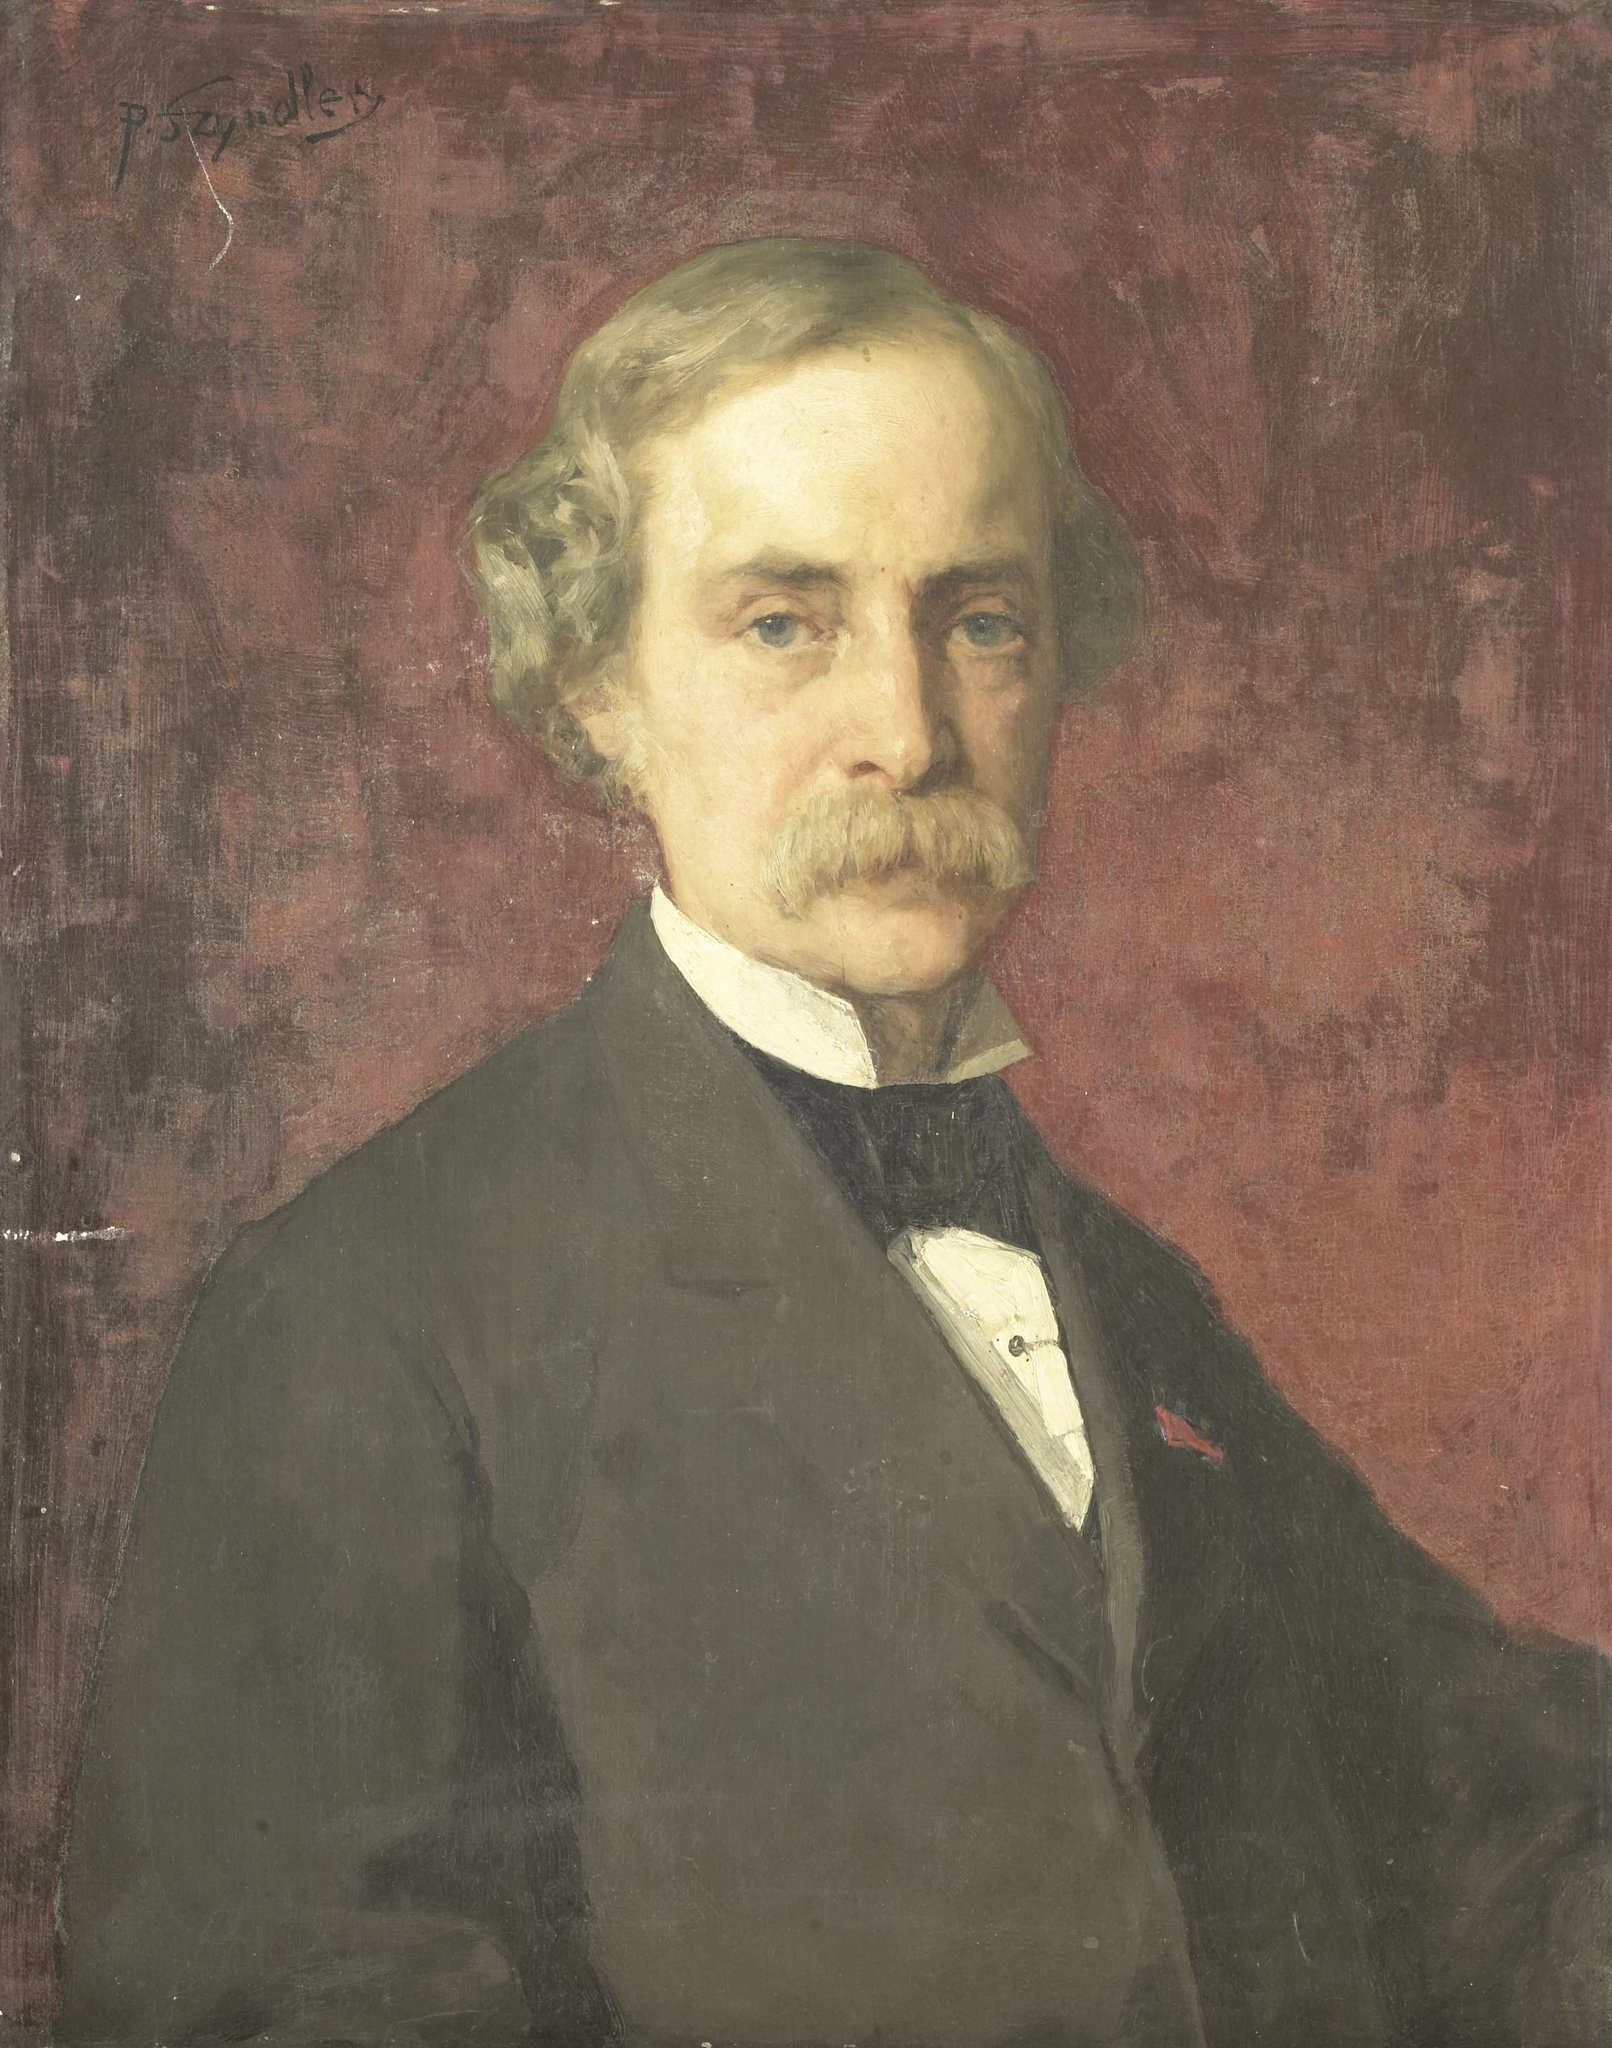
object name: painting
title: Johann Wilhelm Kaiser (1813-1900). Graficus, directeur van de Graveerschool en van het Rijksmuseum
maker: pantaleon szyndler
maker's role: painter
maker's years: 1846-1905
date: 1875-1900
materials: canvas, oil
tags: amsterdam, leiden, print maker, draughtsman, johann wilhelm kaiser (i), rijksmuseum amsterdam, museum personnel, historical persons, portrait, self-portrait of artist, portrait, self-portrait of graphic artist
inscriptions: signature: ‘P. Szyndler’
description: Portret van Johann Wilhelm Kaiser (1813-1900). Graficus, directeur van de Graveerschool en van het Rijksmuseum. Buste naar rechts.